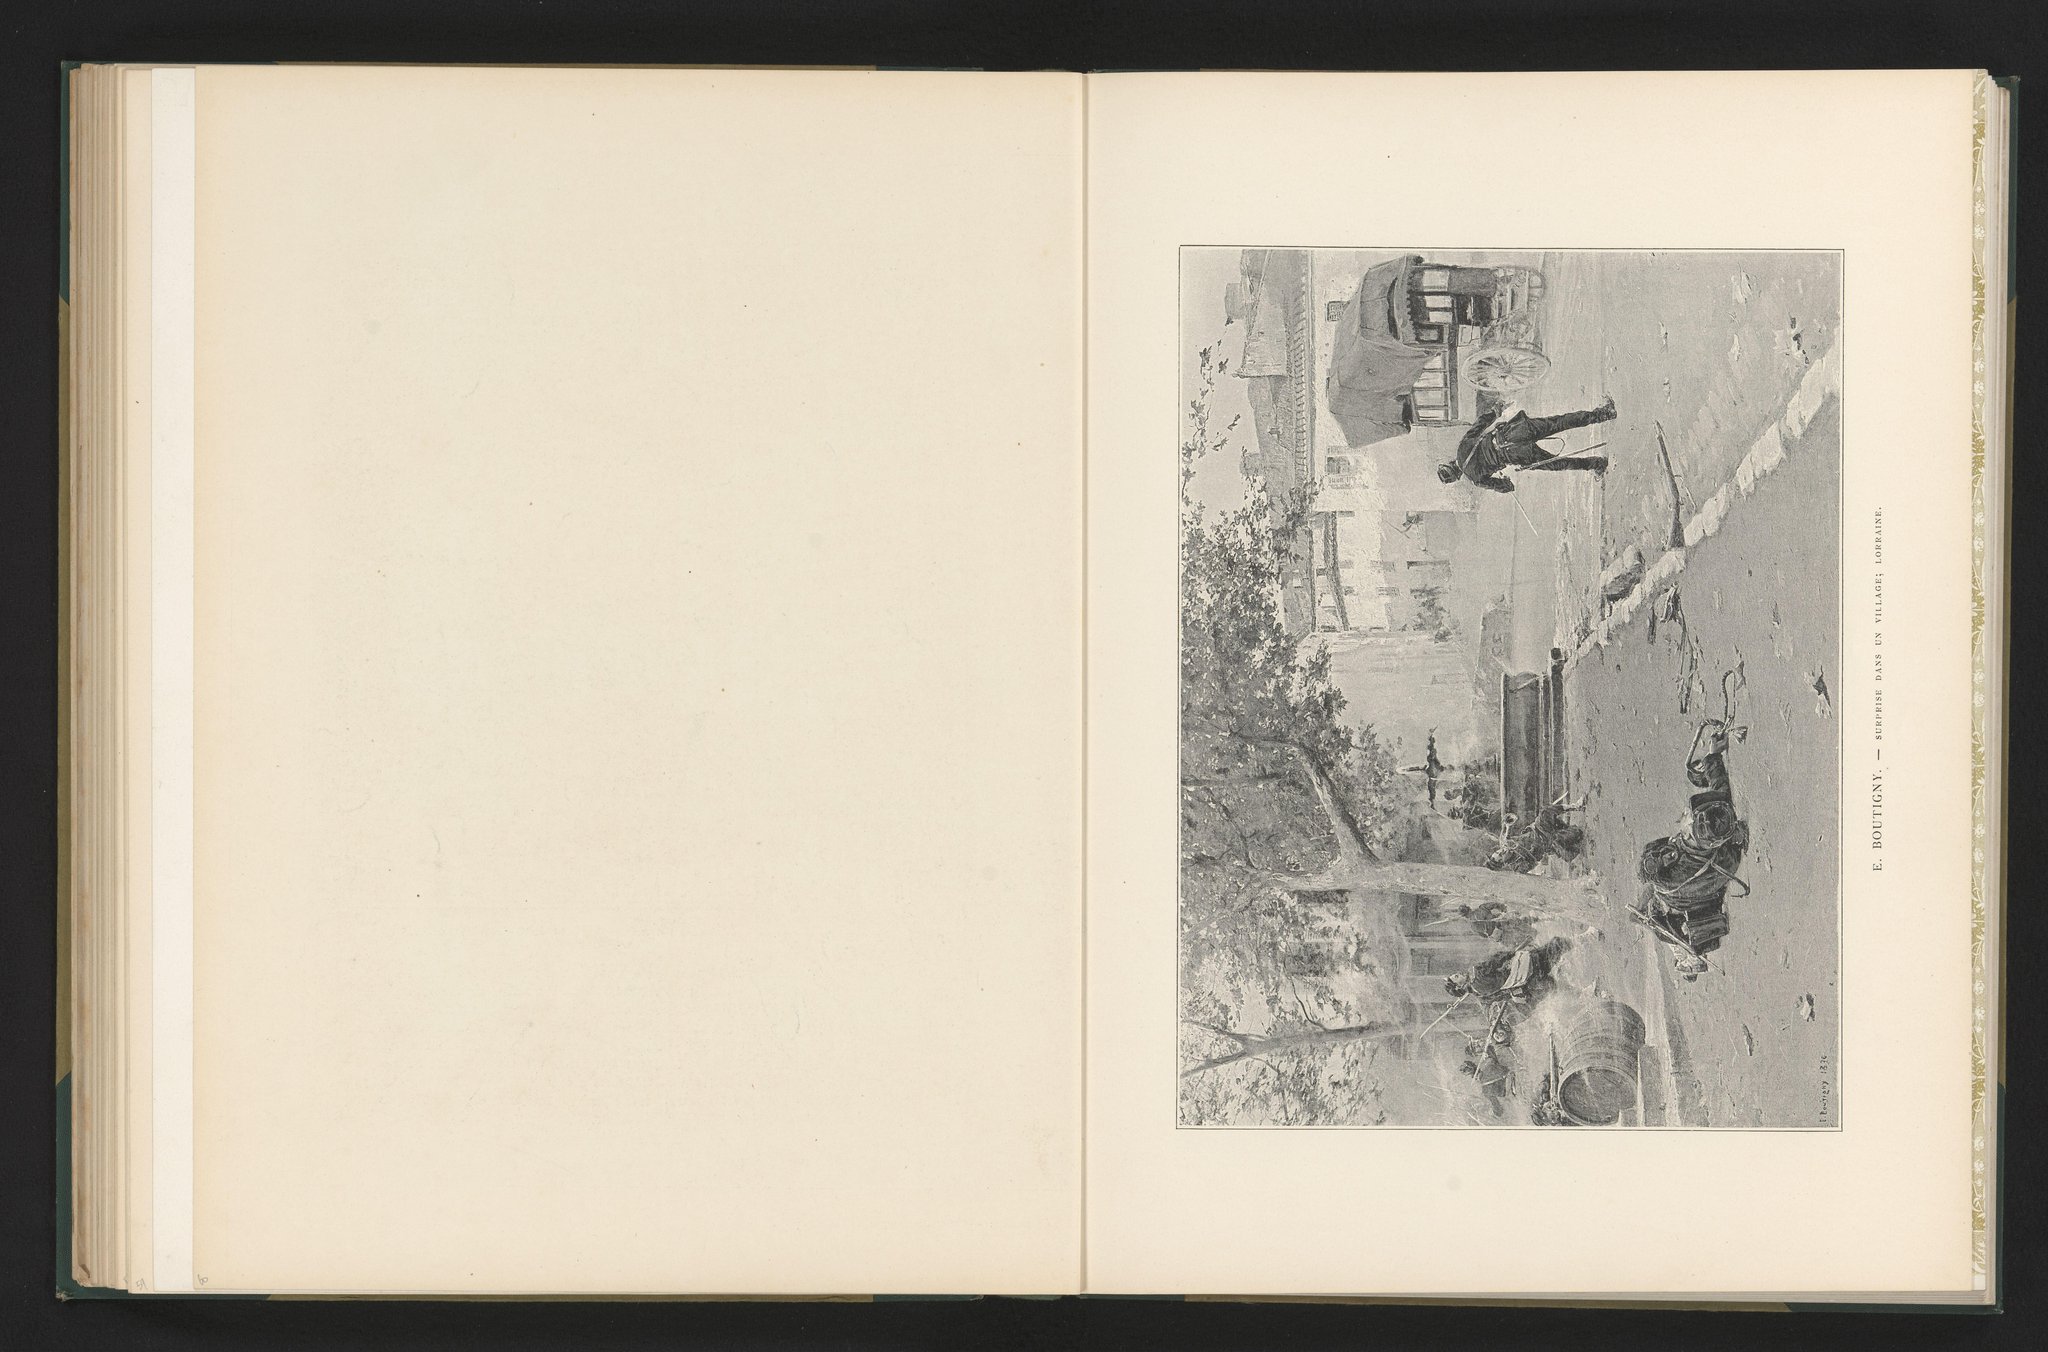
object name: page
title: Reproductie van een schilderij van overvallen militairen in een dorp te Lotharingen door Paul Emile Boutigny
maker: Anonymous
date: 1885-1901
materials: paper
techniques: autotype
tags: battle (+ infantry), village (+ city(-scape) with figures, staffage)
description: Prent op pagina 33 van Figaro-Salon (par Albert Wolff).